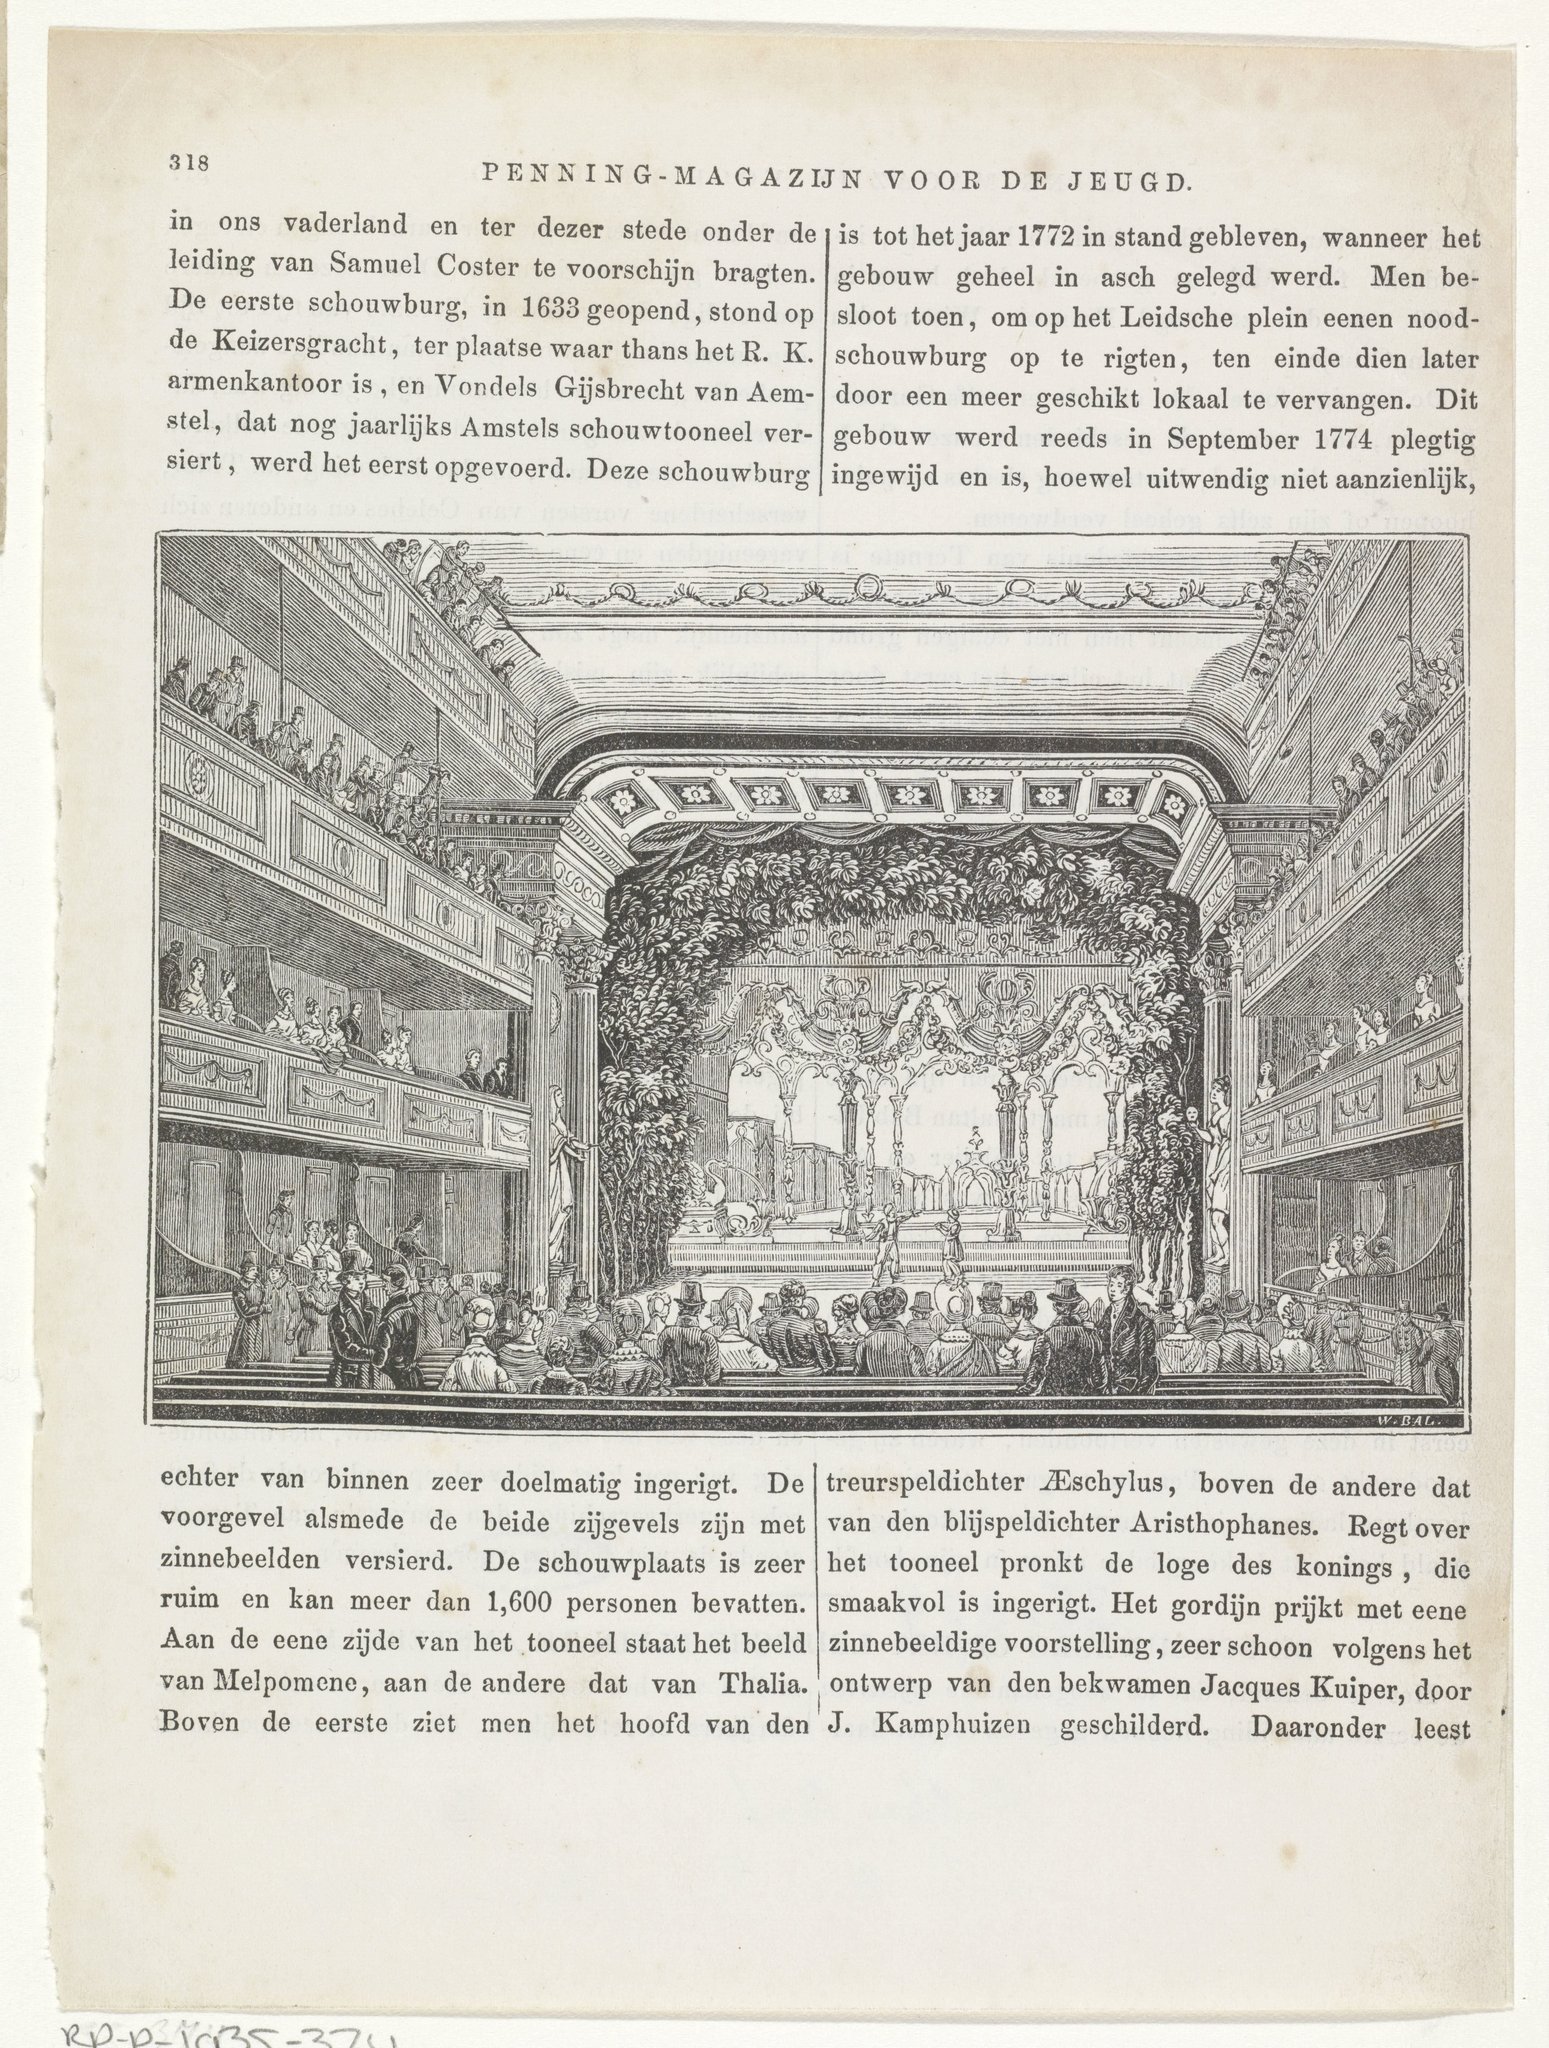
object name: book illustration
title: Interieur van een schouwburg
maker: willem bal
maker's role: print maker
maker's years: 1808-1897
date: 1818-1897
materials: paper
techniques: letterpress printing, engraving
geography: netherlands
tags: theatre, theatrical performance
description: Prent uit: Penning-magazijn voor de jeugd.